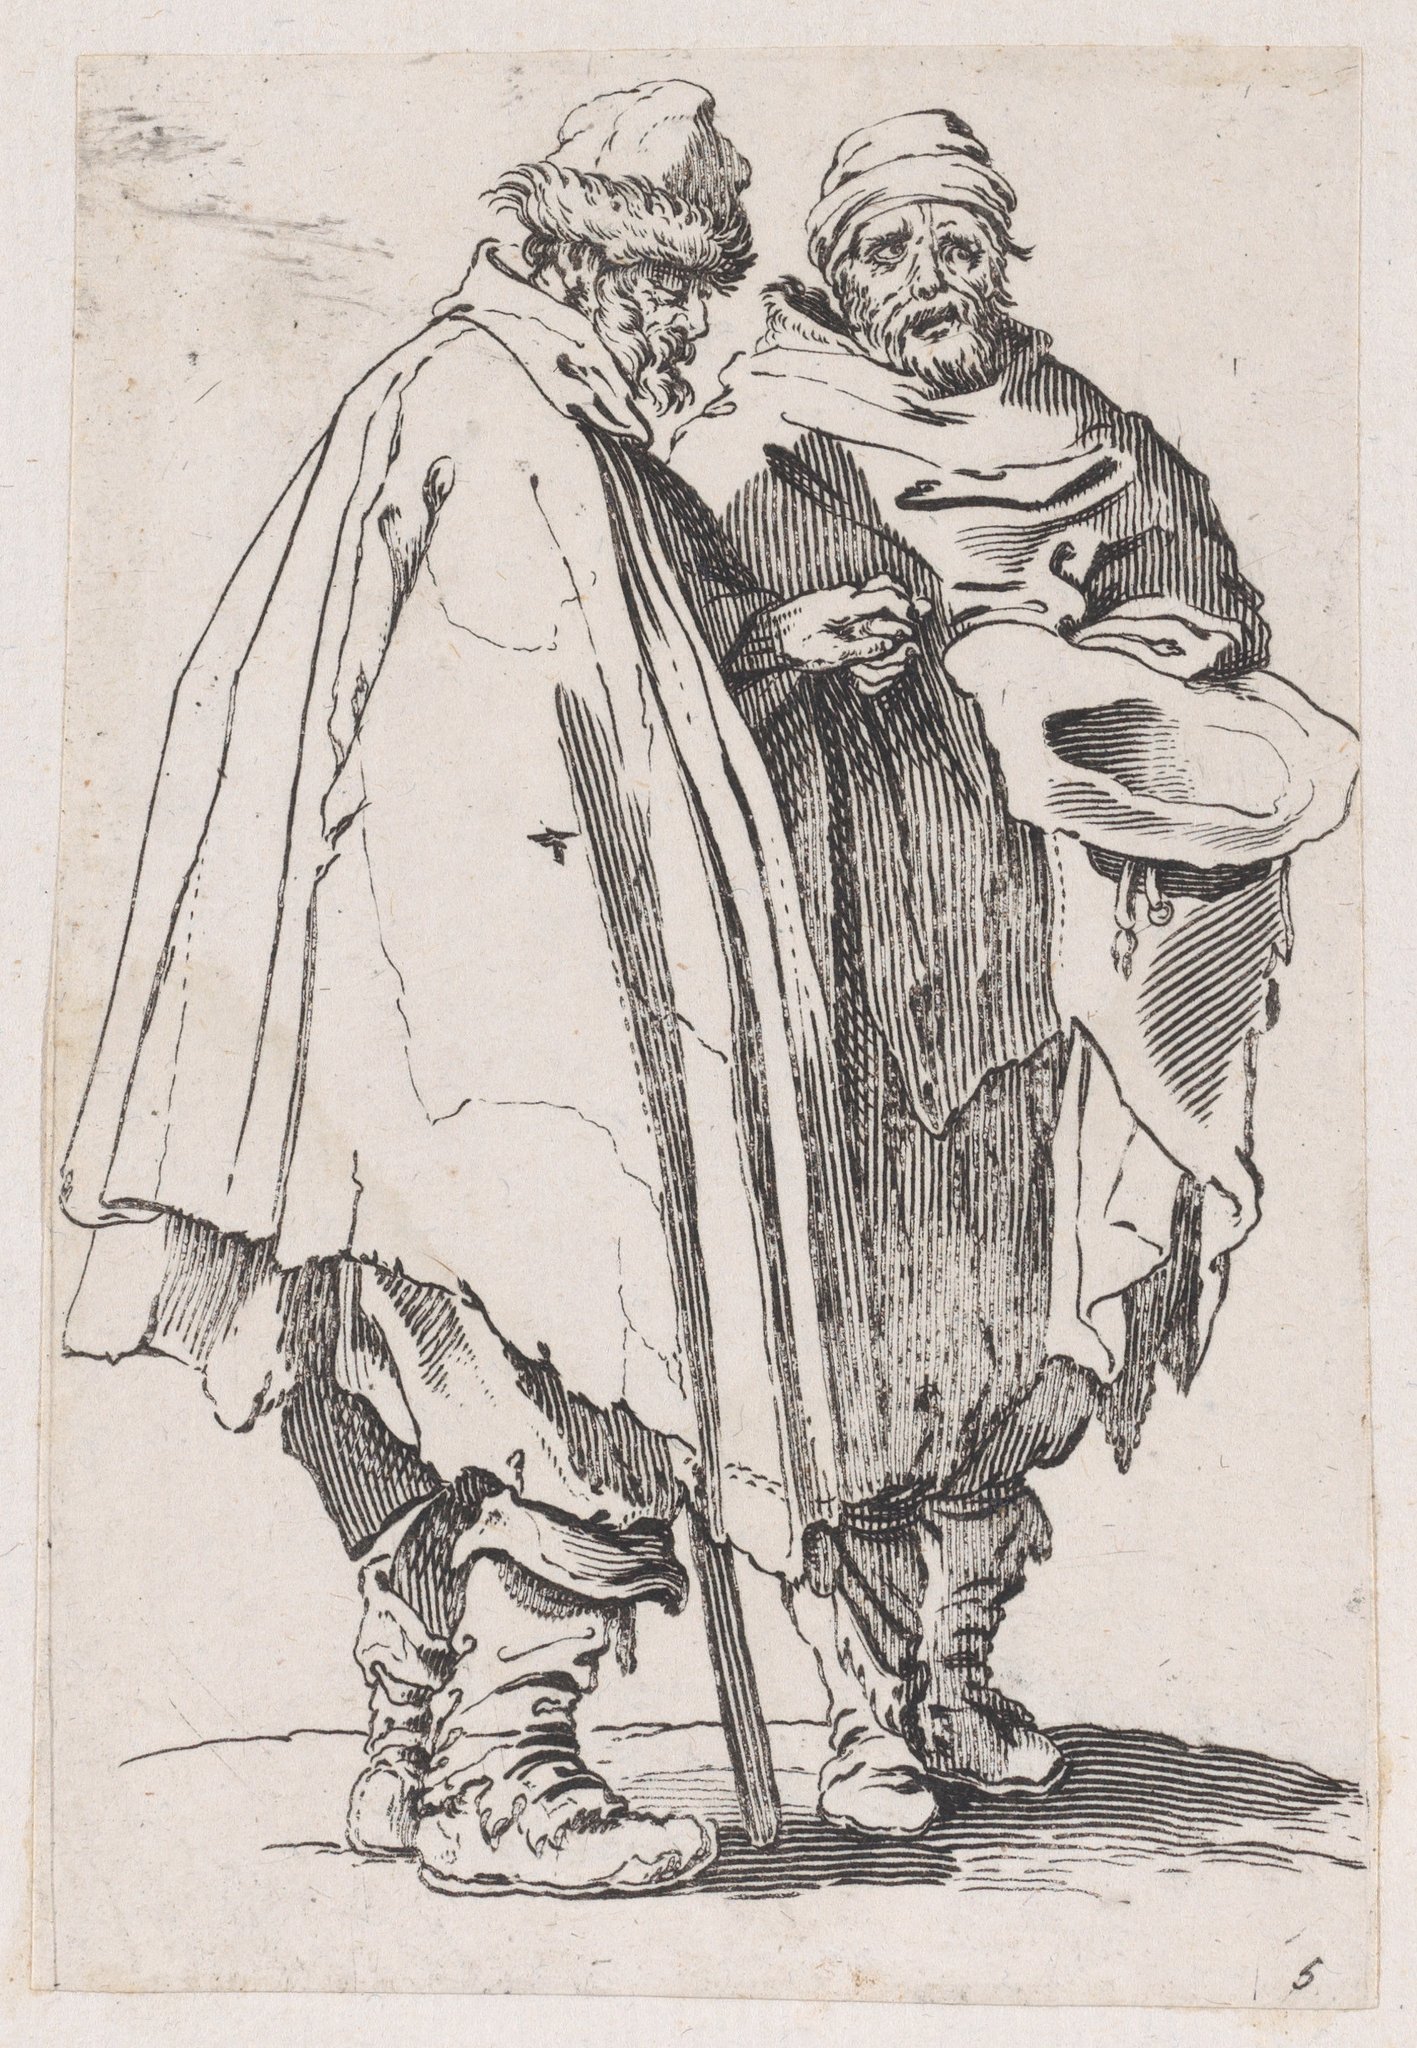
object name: print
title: Reverse Copy of L'Aveugle et son Compagnon (The Blind Man and his Companion), from Les Gueux suite appelée aussi Les Mendiants, Les Baroni, ou Les Barons (The Beggars, also called the Barons)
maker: Anonymous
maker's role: artist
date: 1601-1700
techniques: etching